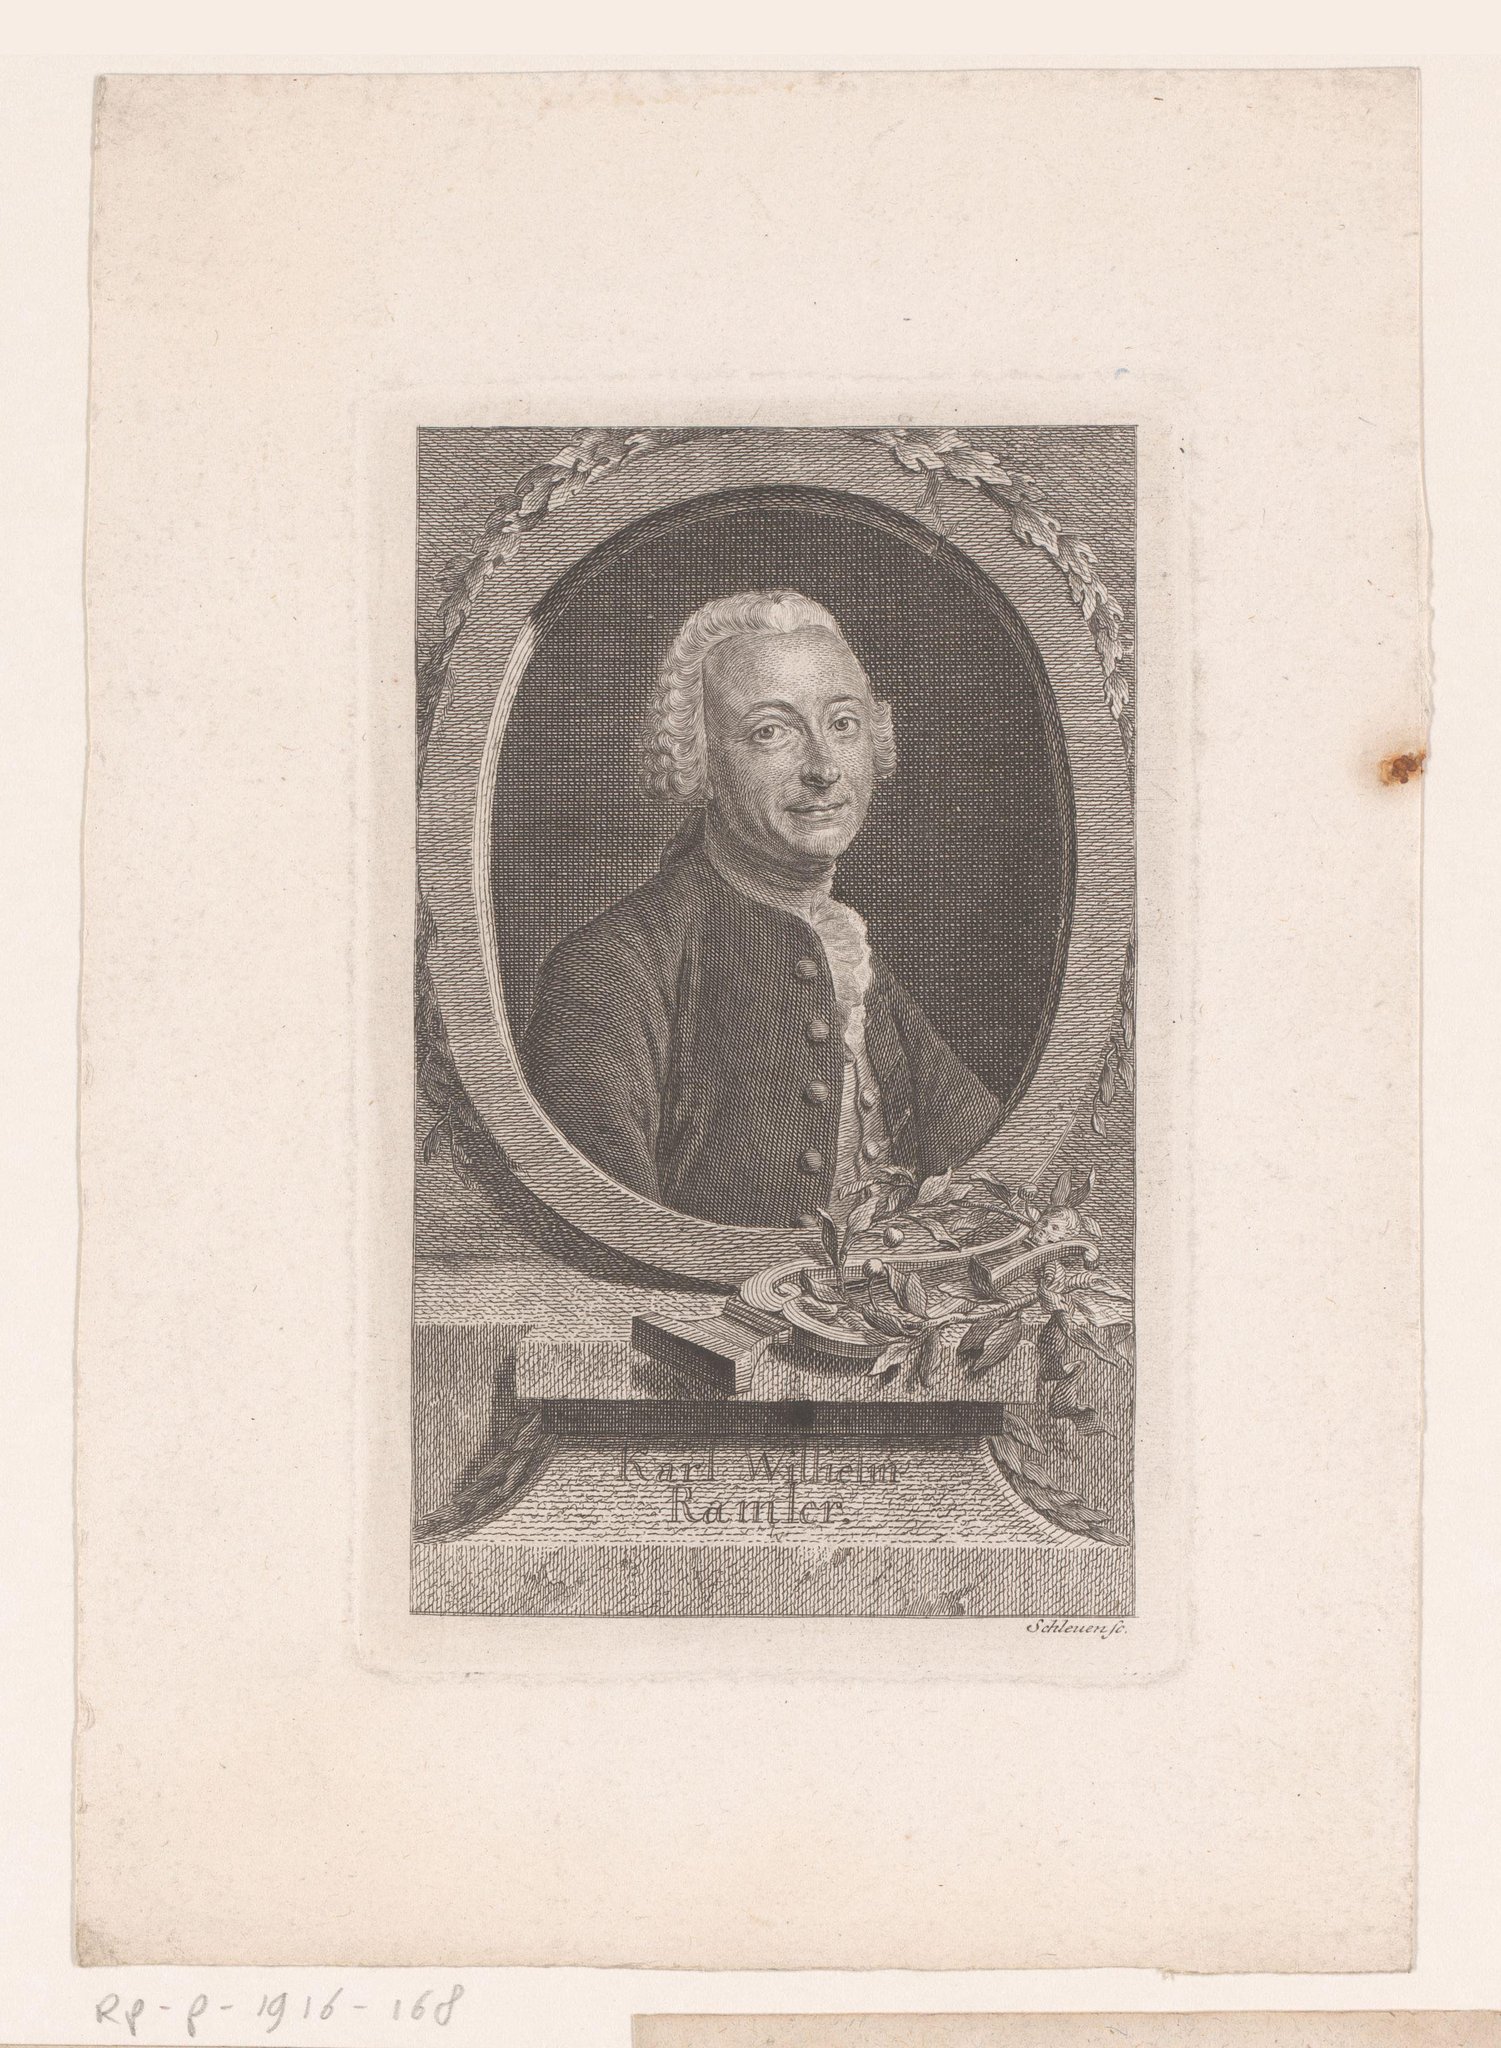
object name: print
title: Portret van Karl Wilhelm Ramler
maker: johann friedrich schleuen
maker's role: print maker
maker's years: 1739-1784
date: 1721-1771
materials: paper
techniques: engraving, etching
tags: berlin, lyre, cithara, psaltery, historical persons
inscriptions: collector's mark: Lugt 2228